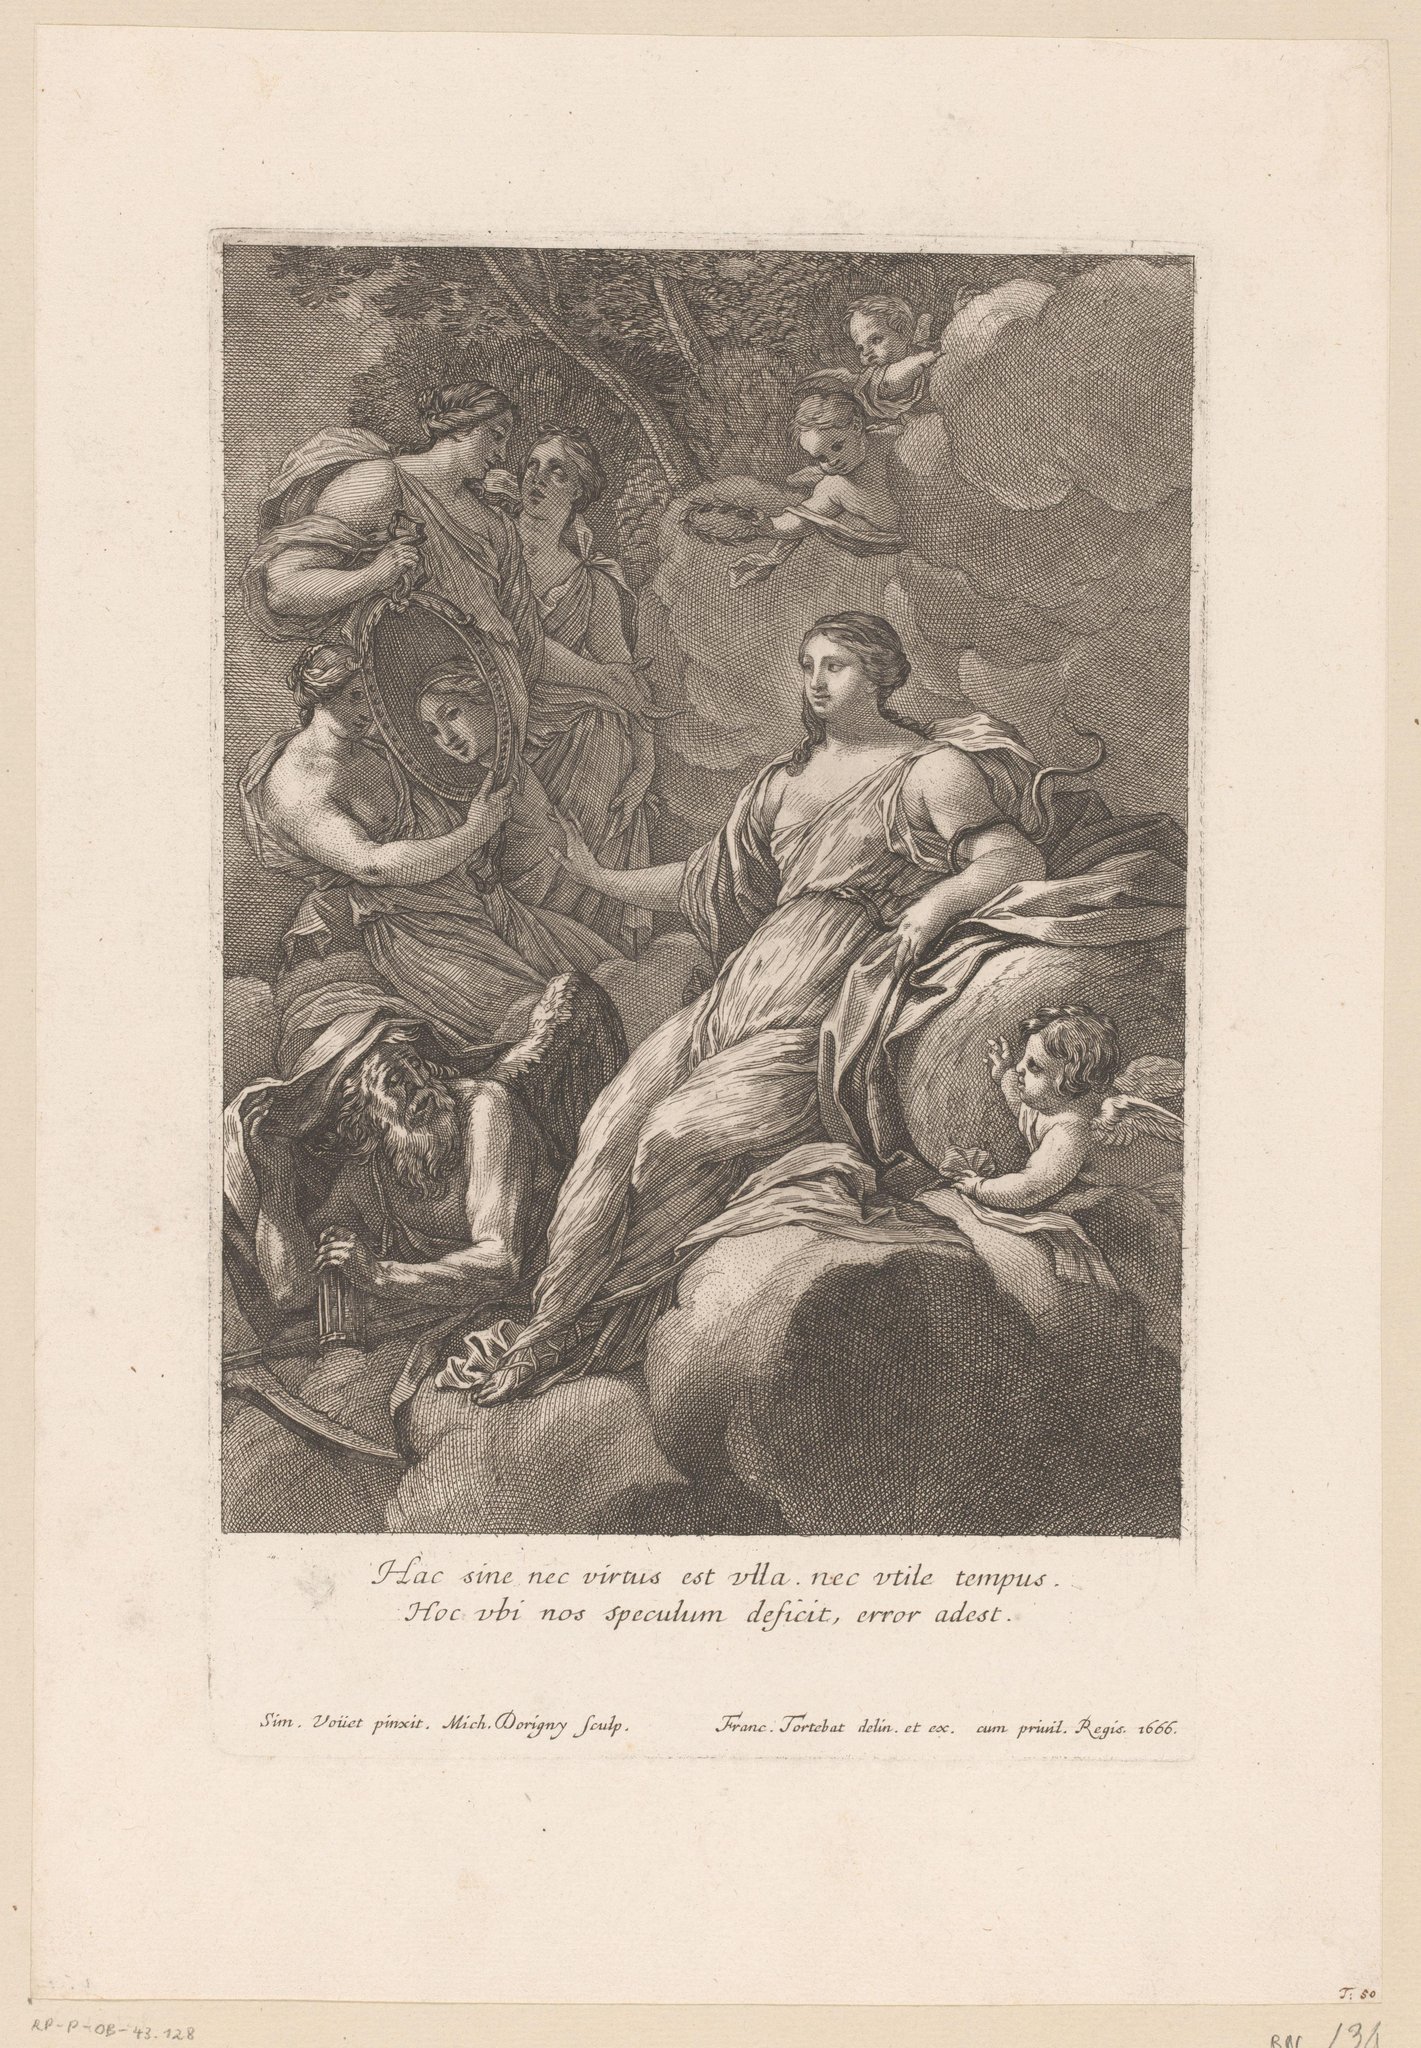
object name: print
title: Allegorische voorstelling over vanitas en reflectie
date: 1666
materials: paper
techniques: engraving, etching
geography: france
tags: scenes symbolizing 'vanitas', reflection (in a mirror)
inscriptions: collector's mark: Lugt 240